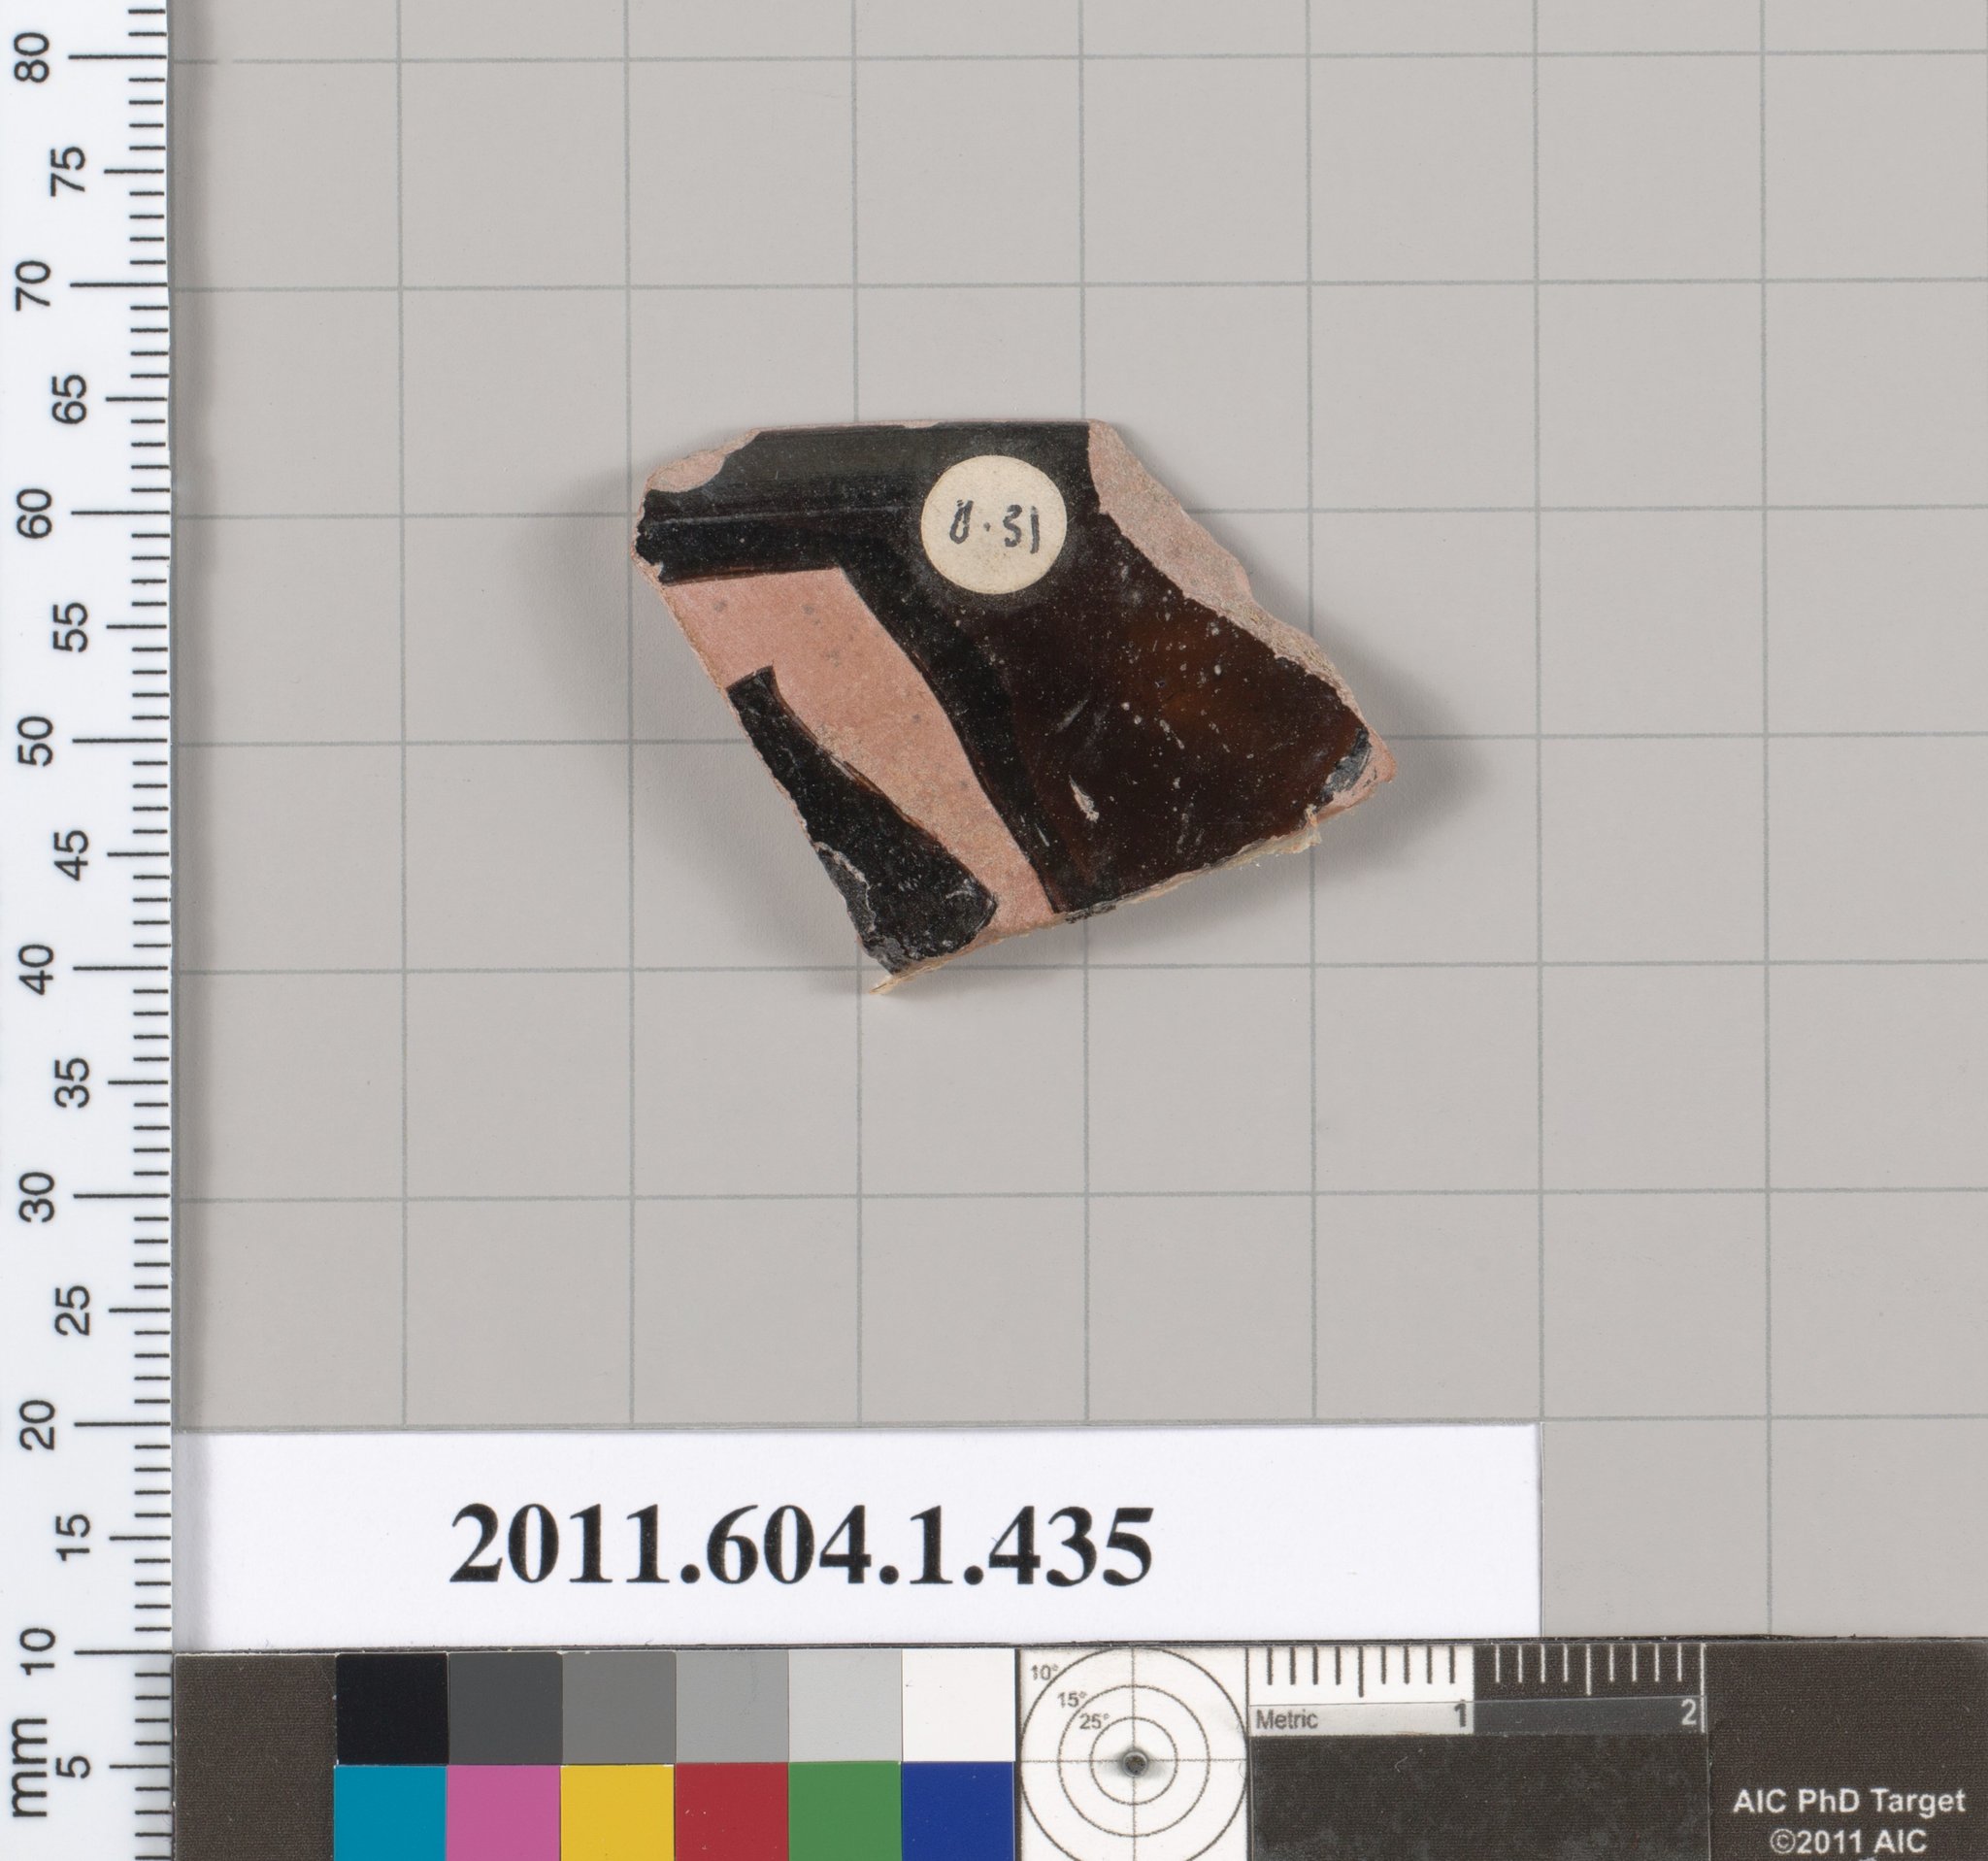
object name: kylix fragment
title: Terracotta rim fragment of a kylix (drinking cup)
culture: greek, attic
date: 475-451 BCE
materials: terracotta